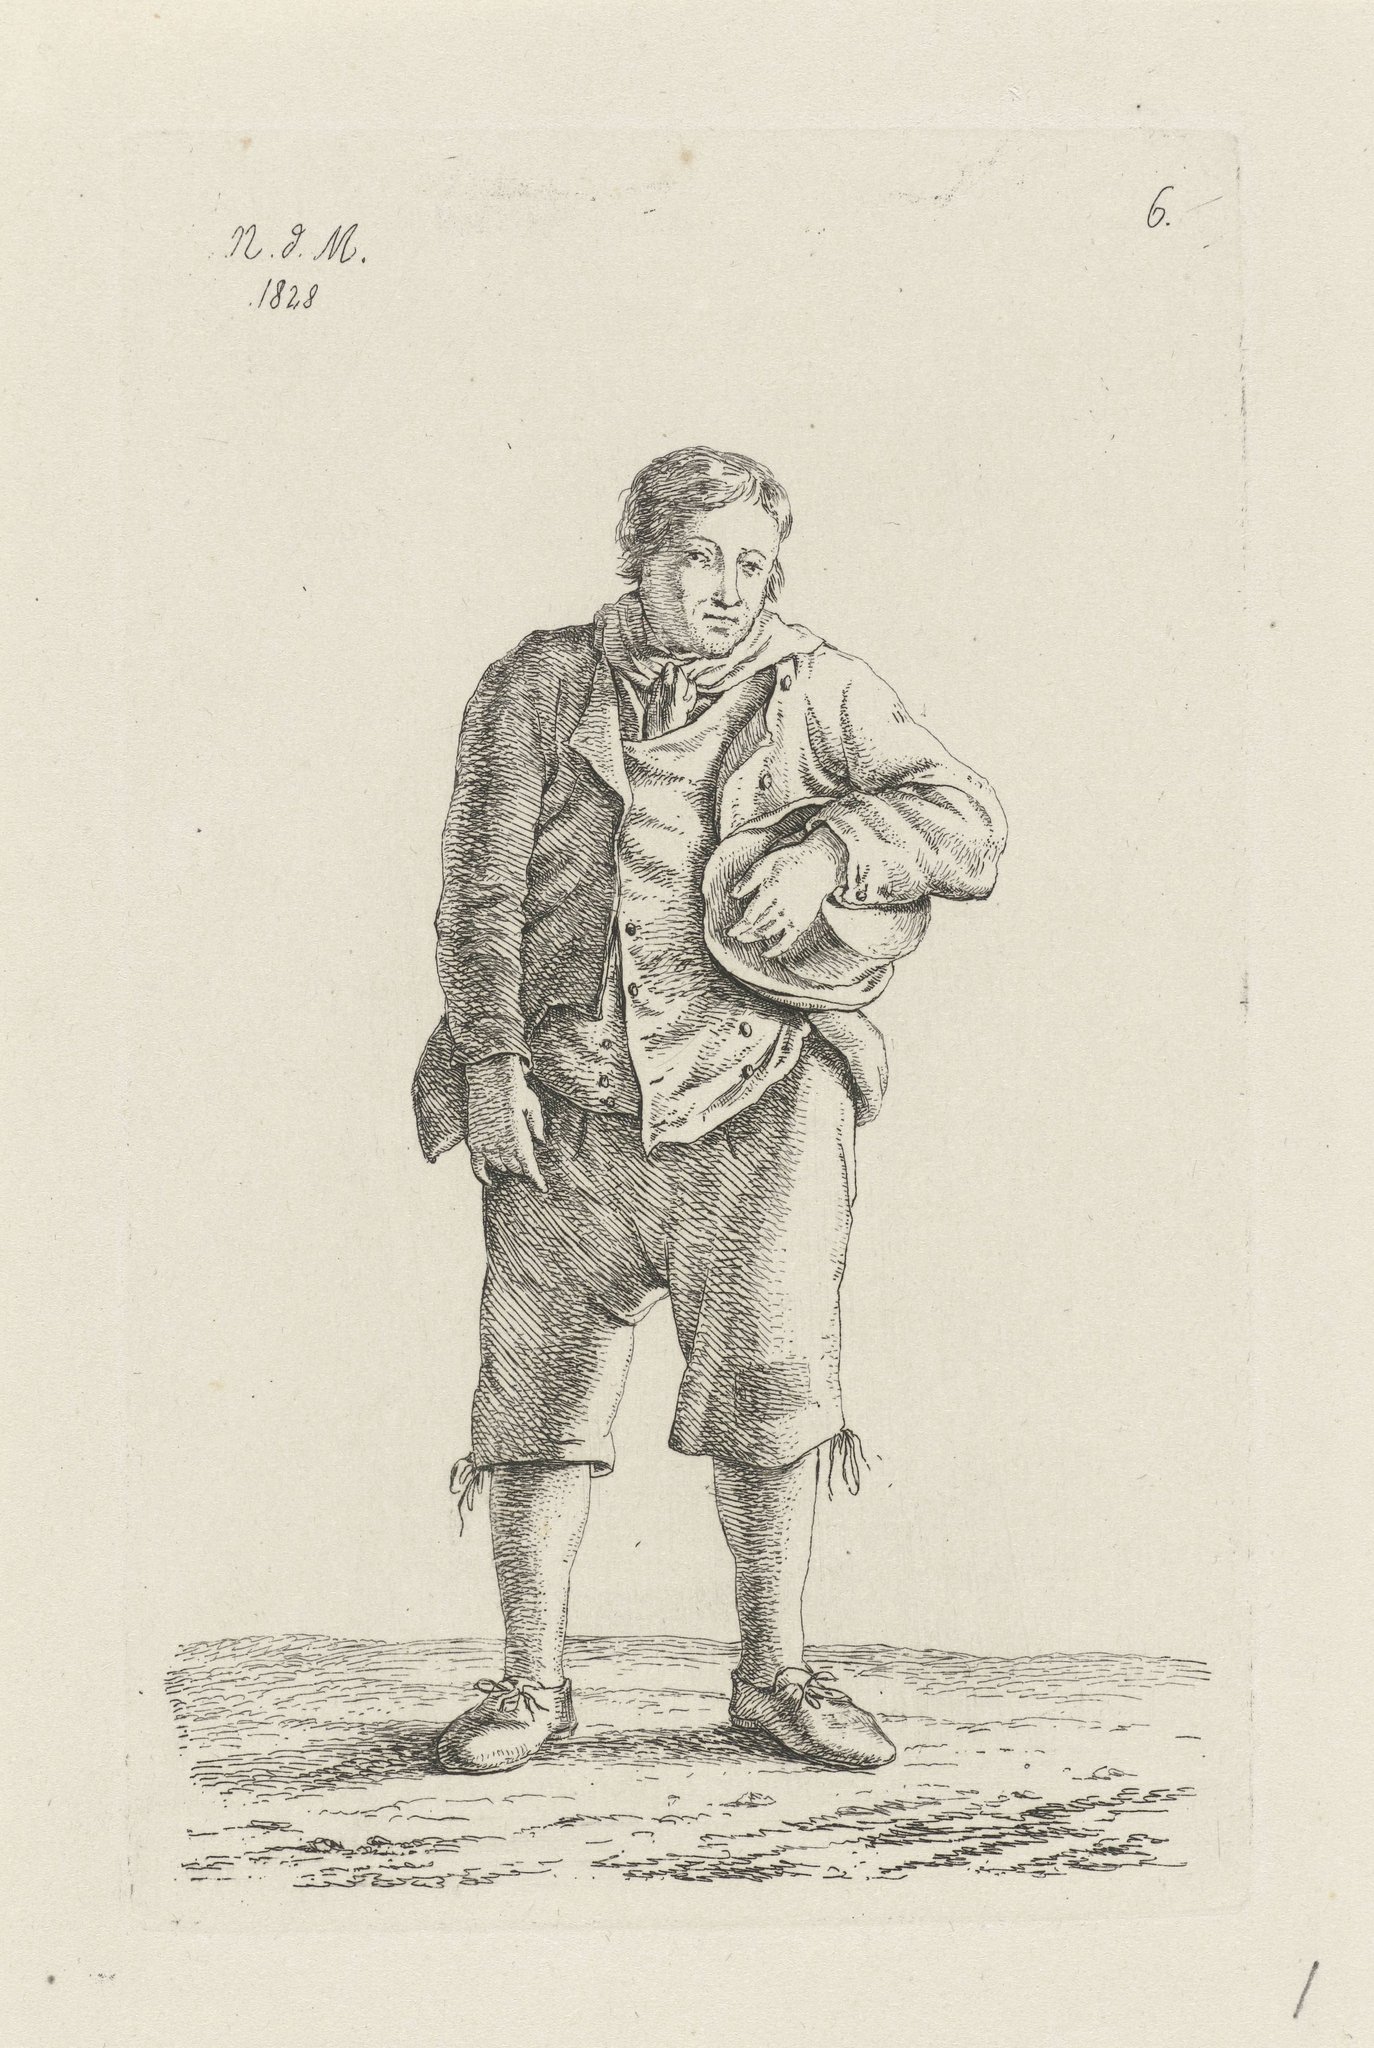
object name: print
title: Boeren en boerinnen uit het Verenigd Koninkrijk der Nederlanden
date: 1828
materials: paper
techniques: etching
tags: standing figure (+ front view), mechelen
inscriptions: collector's mark: Lugt 2228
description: Een staande boer uit Mechelen. Proefdruk van de zesde prent uit een serie van zes prenten met voorstellingen van verschillende boeren en boerinnen uit het Verenigd Koninkrijk der Nederlanden.